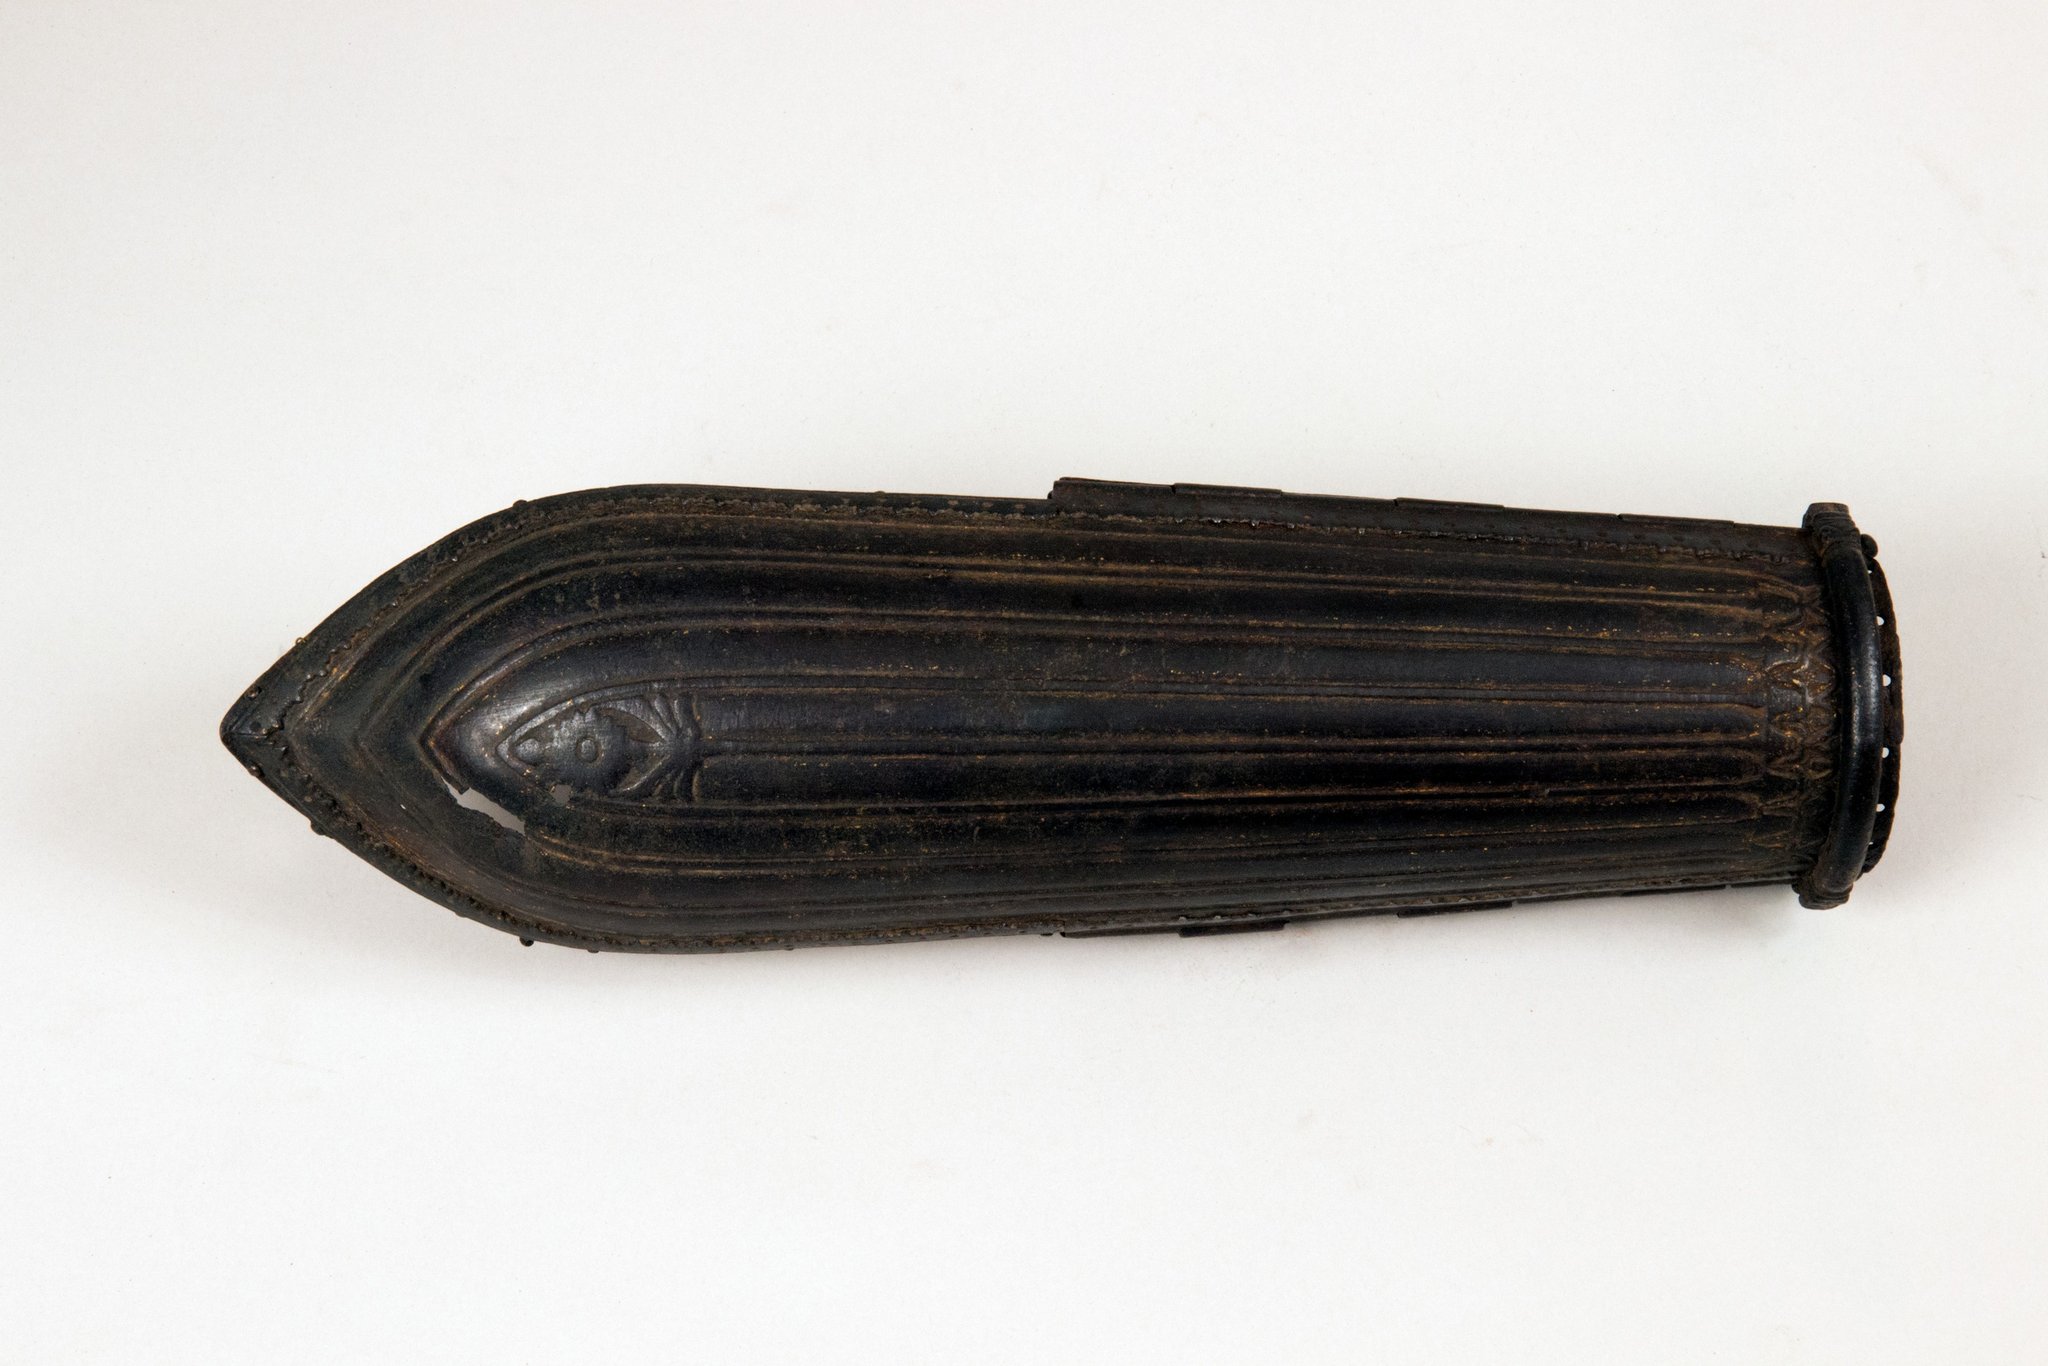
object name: arm guard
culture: indian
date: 1601-1800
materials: steel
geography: india